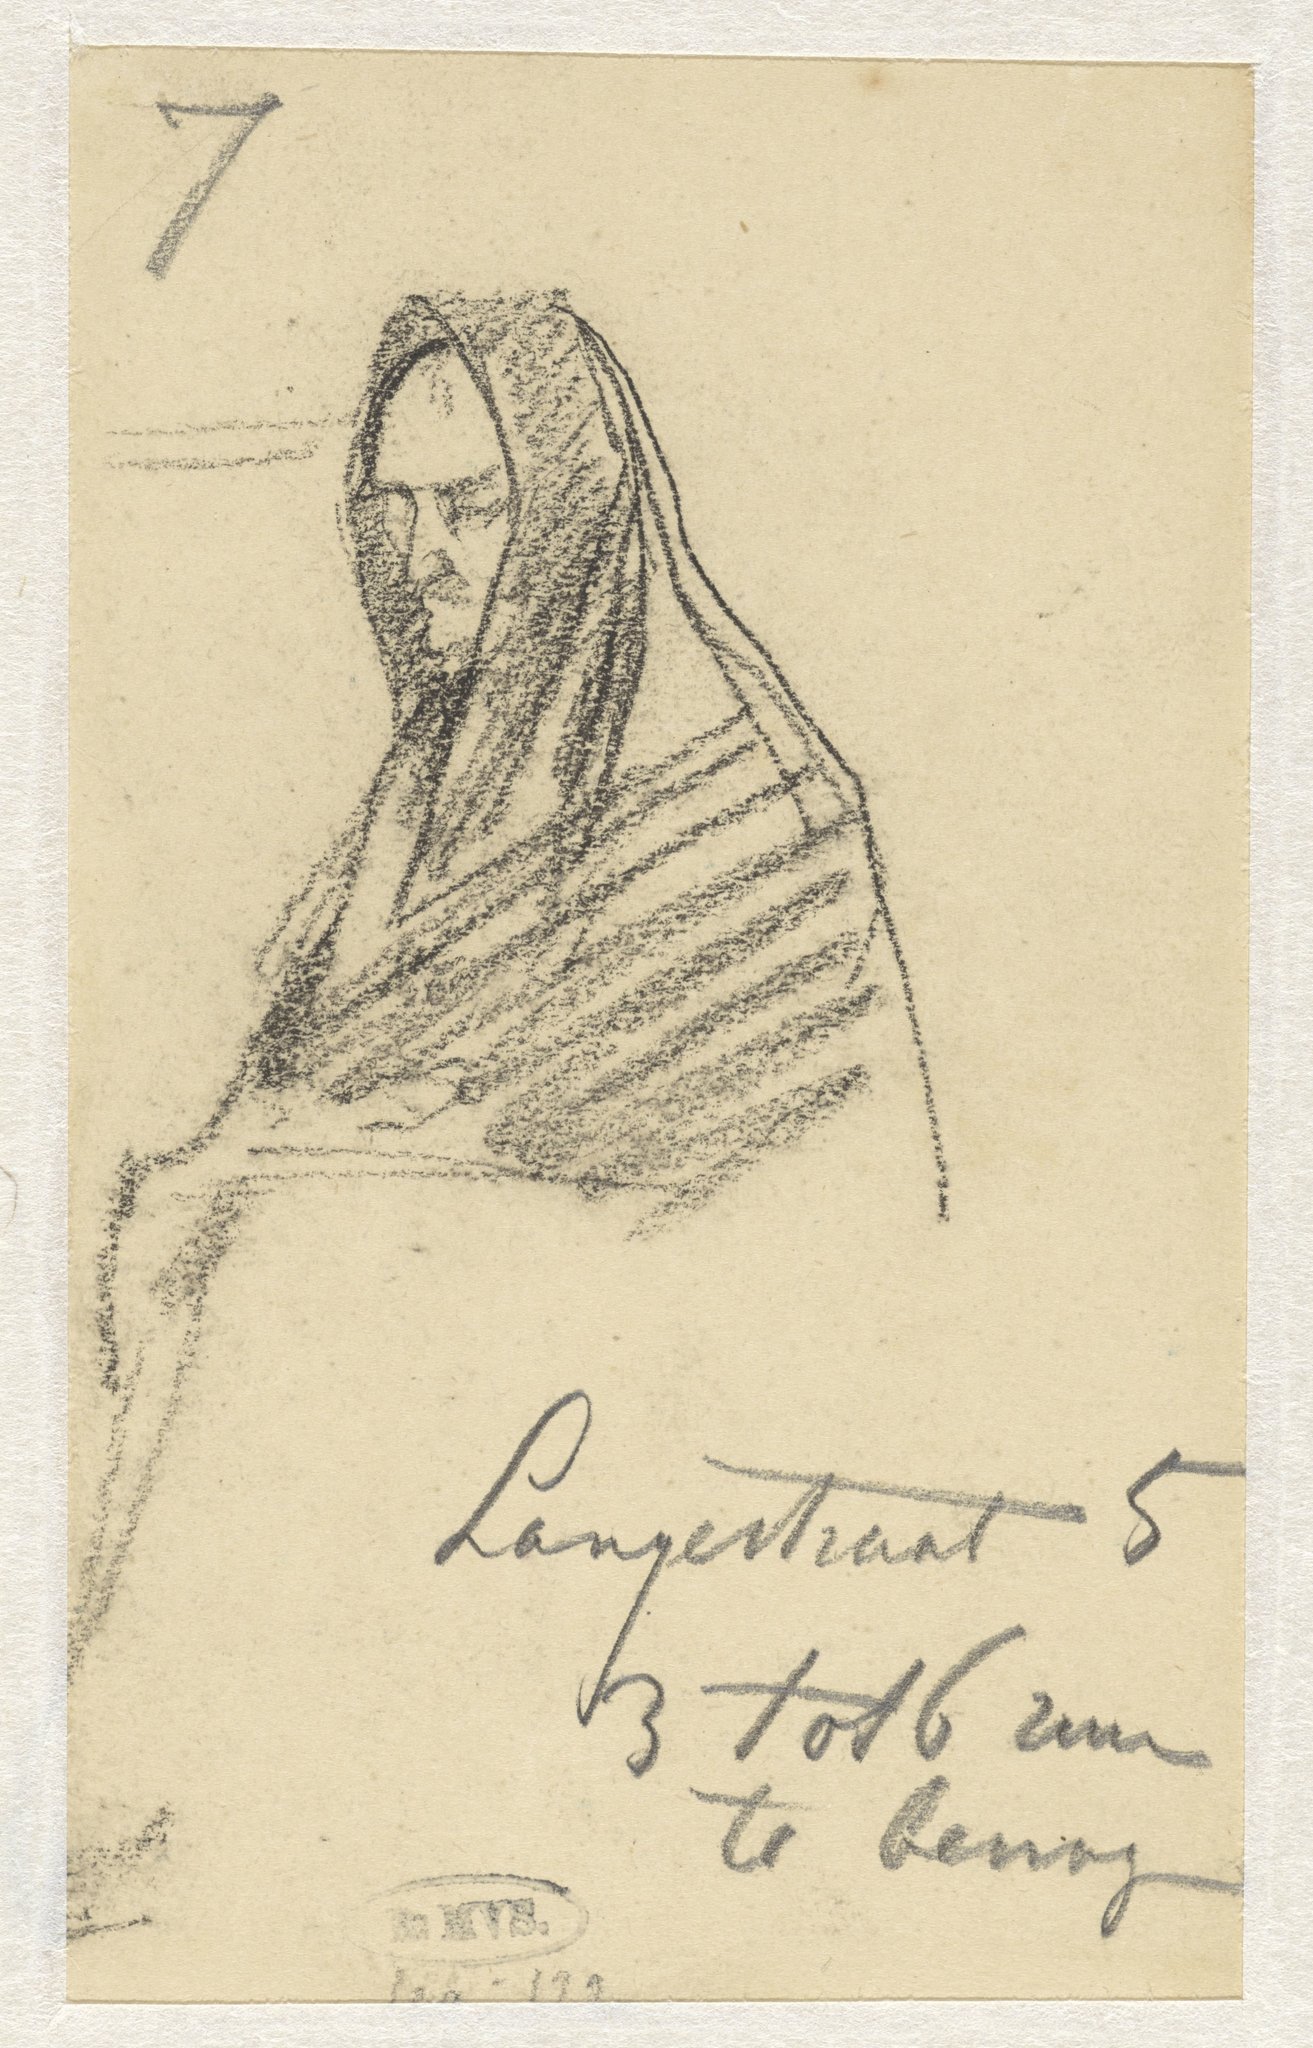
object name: drawing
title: Persoon met mantel over het hoofd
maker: jac van looij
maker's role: draughtsman, painter, print maker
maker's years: 1855-1930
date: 1865-1930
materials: chalk, paper